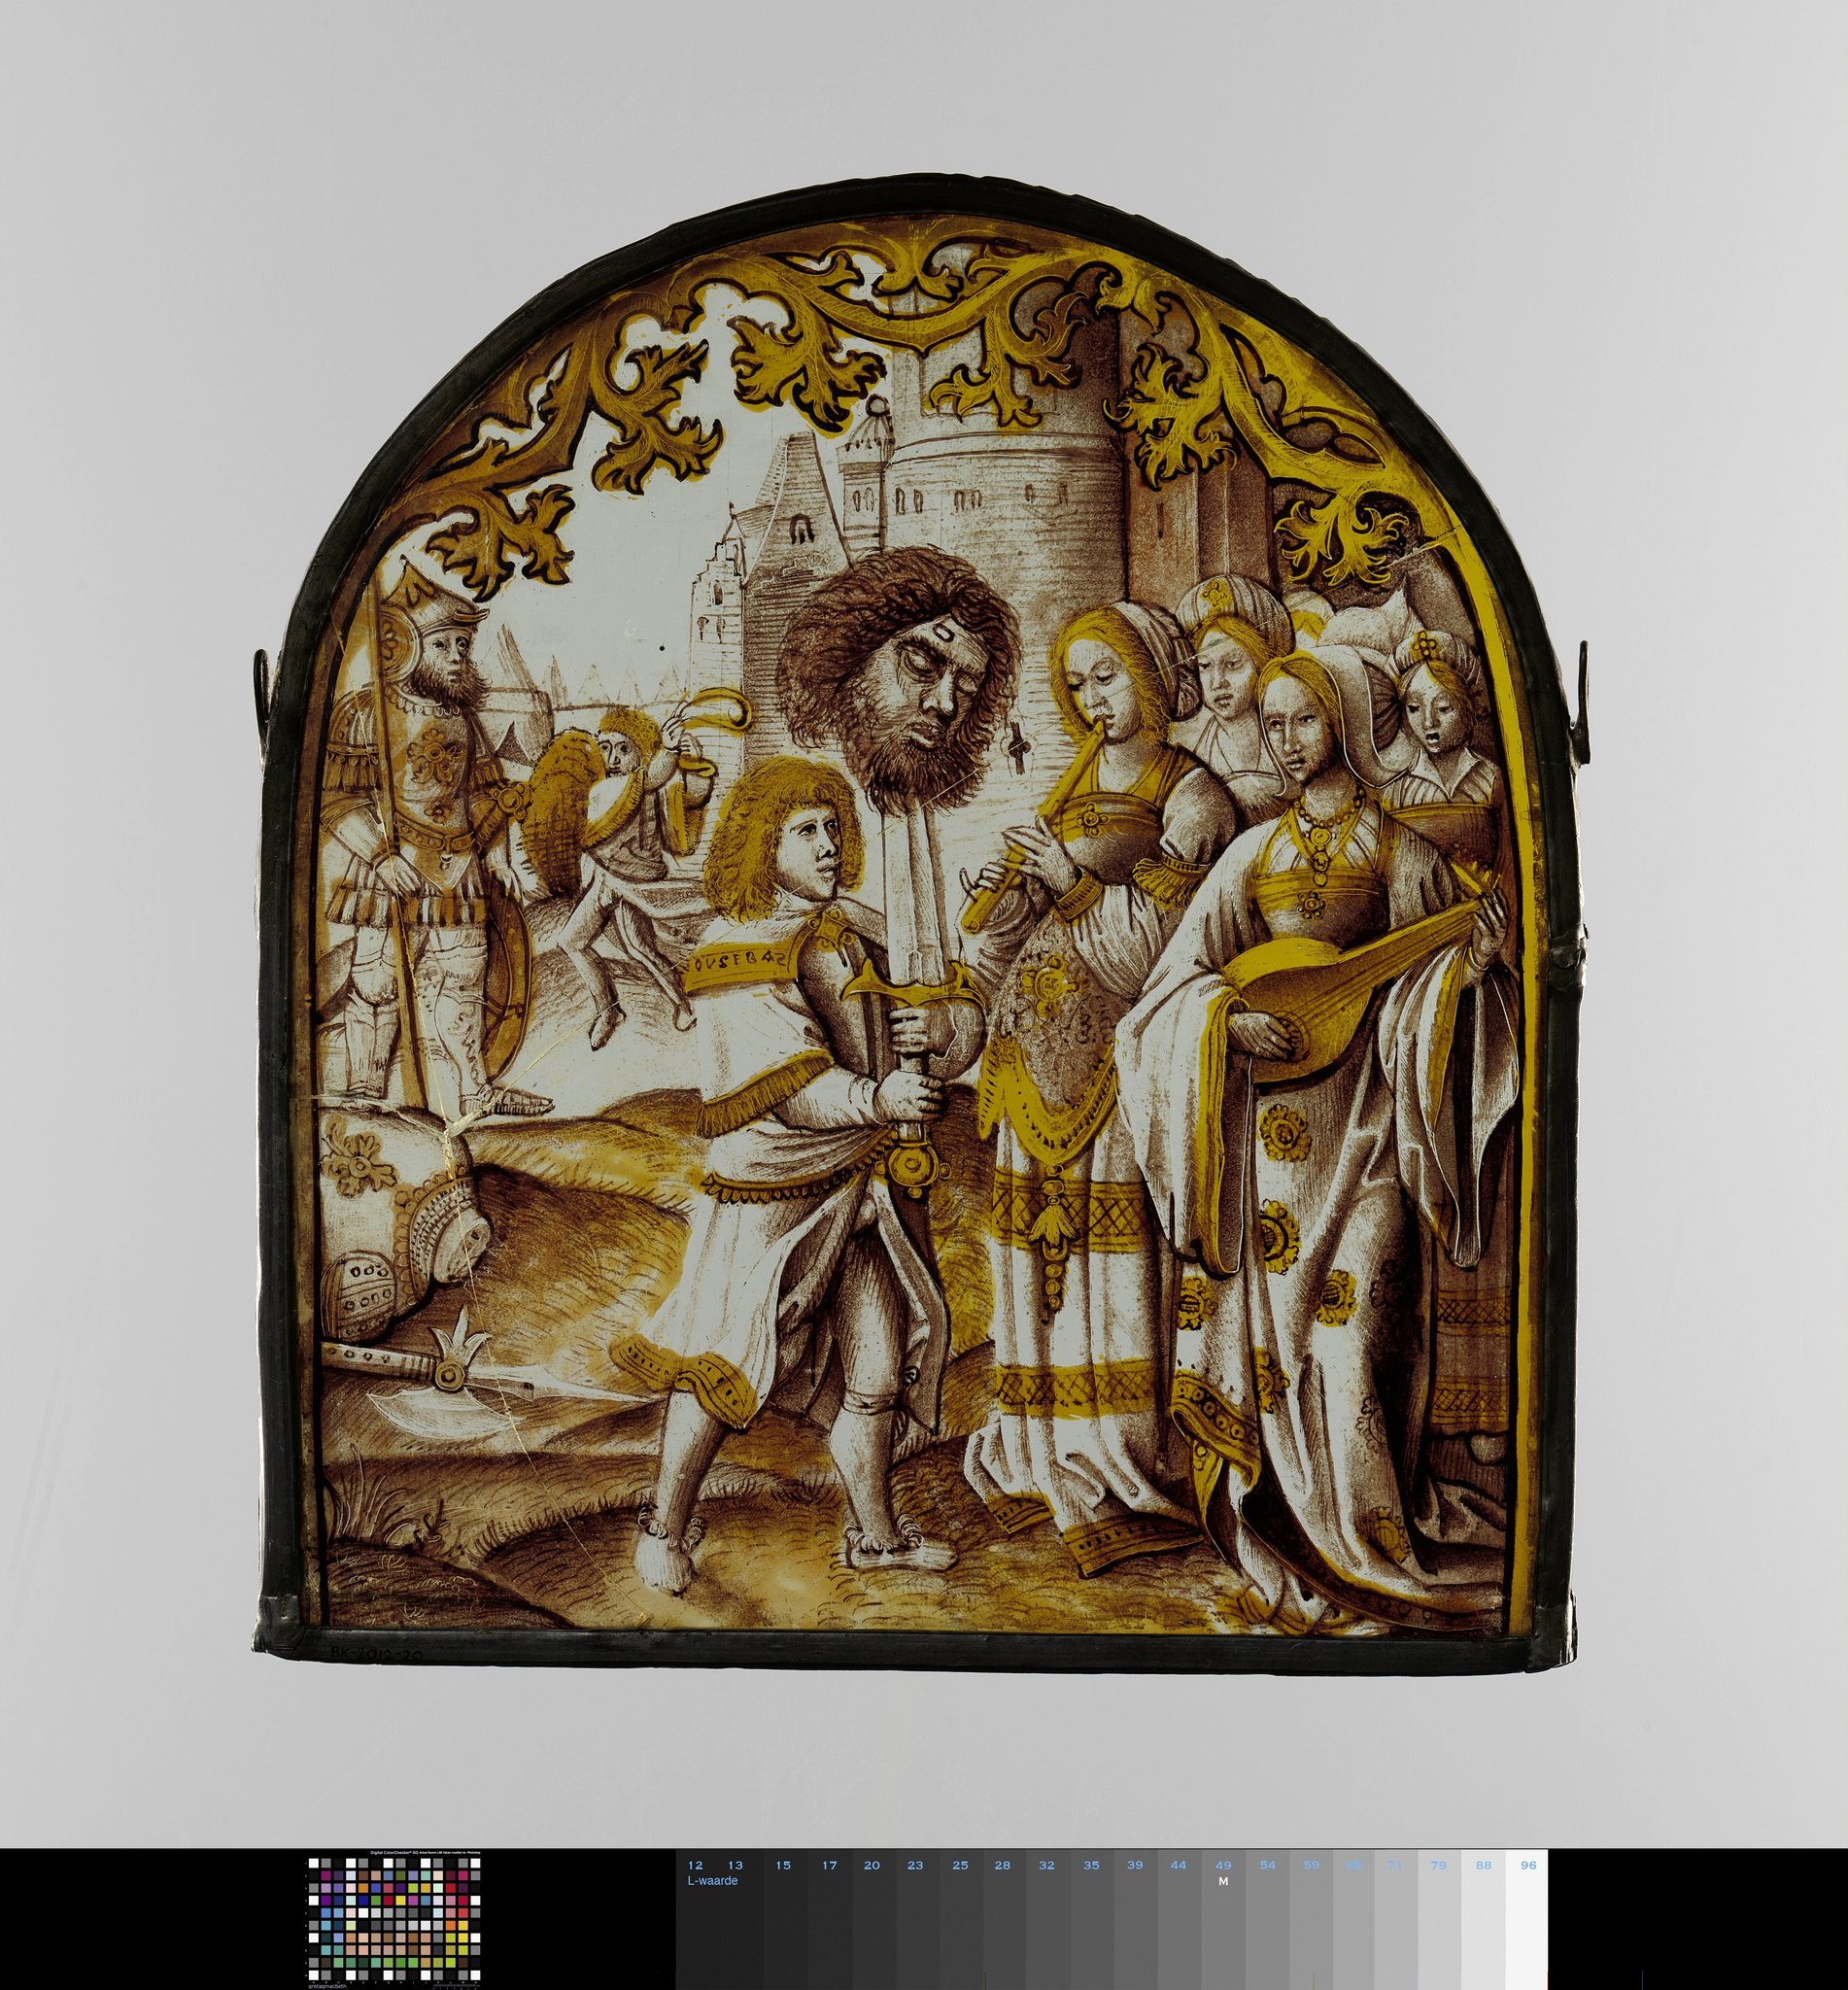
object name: stained glass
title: De triomf van David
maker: Anonymous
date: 1520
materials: glass, lead, pigment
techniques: enamel painting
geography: leiden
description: David en Goliath (1 Samuël 17:51ff). Ruit van gebrandschilderd glas in grisaille en zilvergeel, boogvormig. De scene wordt aan de gebogen bovenzijde afgesloten door een rand van Gotisch acanthuswerk, voortspruitend uit de rand van de voorstelling. De ruit behoort tot een reeks gewijd aan oudtestamentische scenes uit het leven van David.